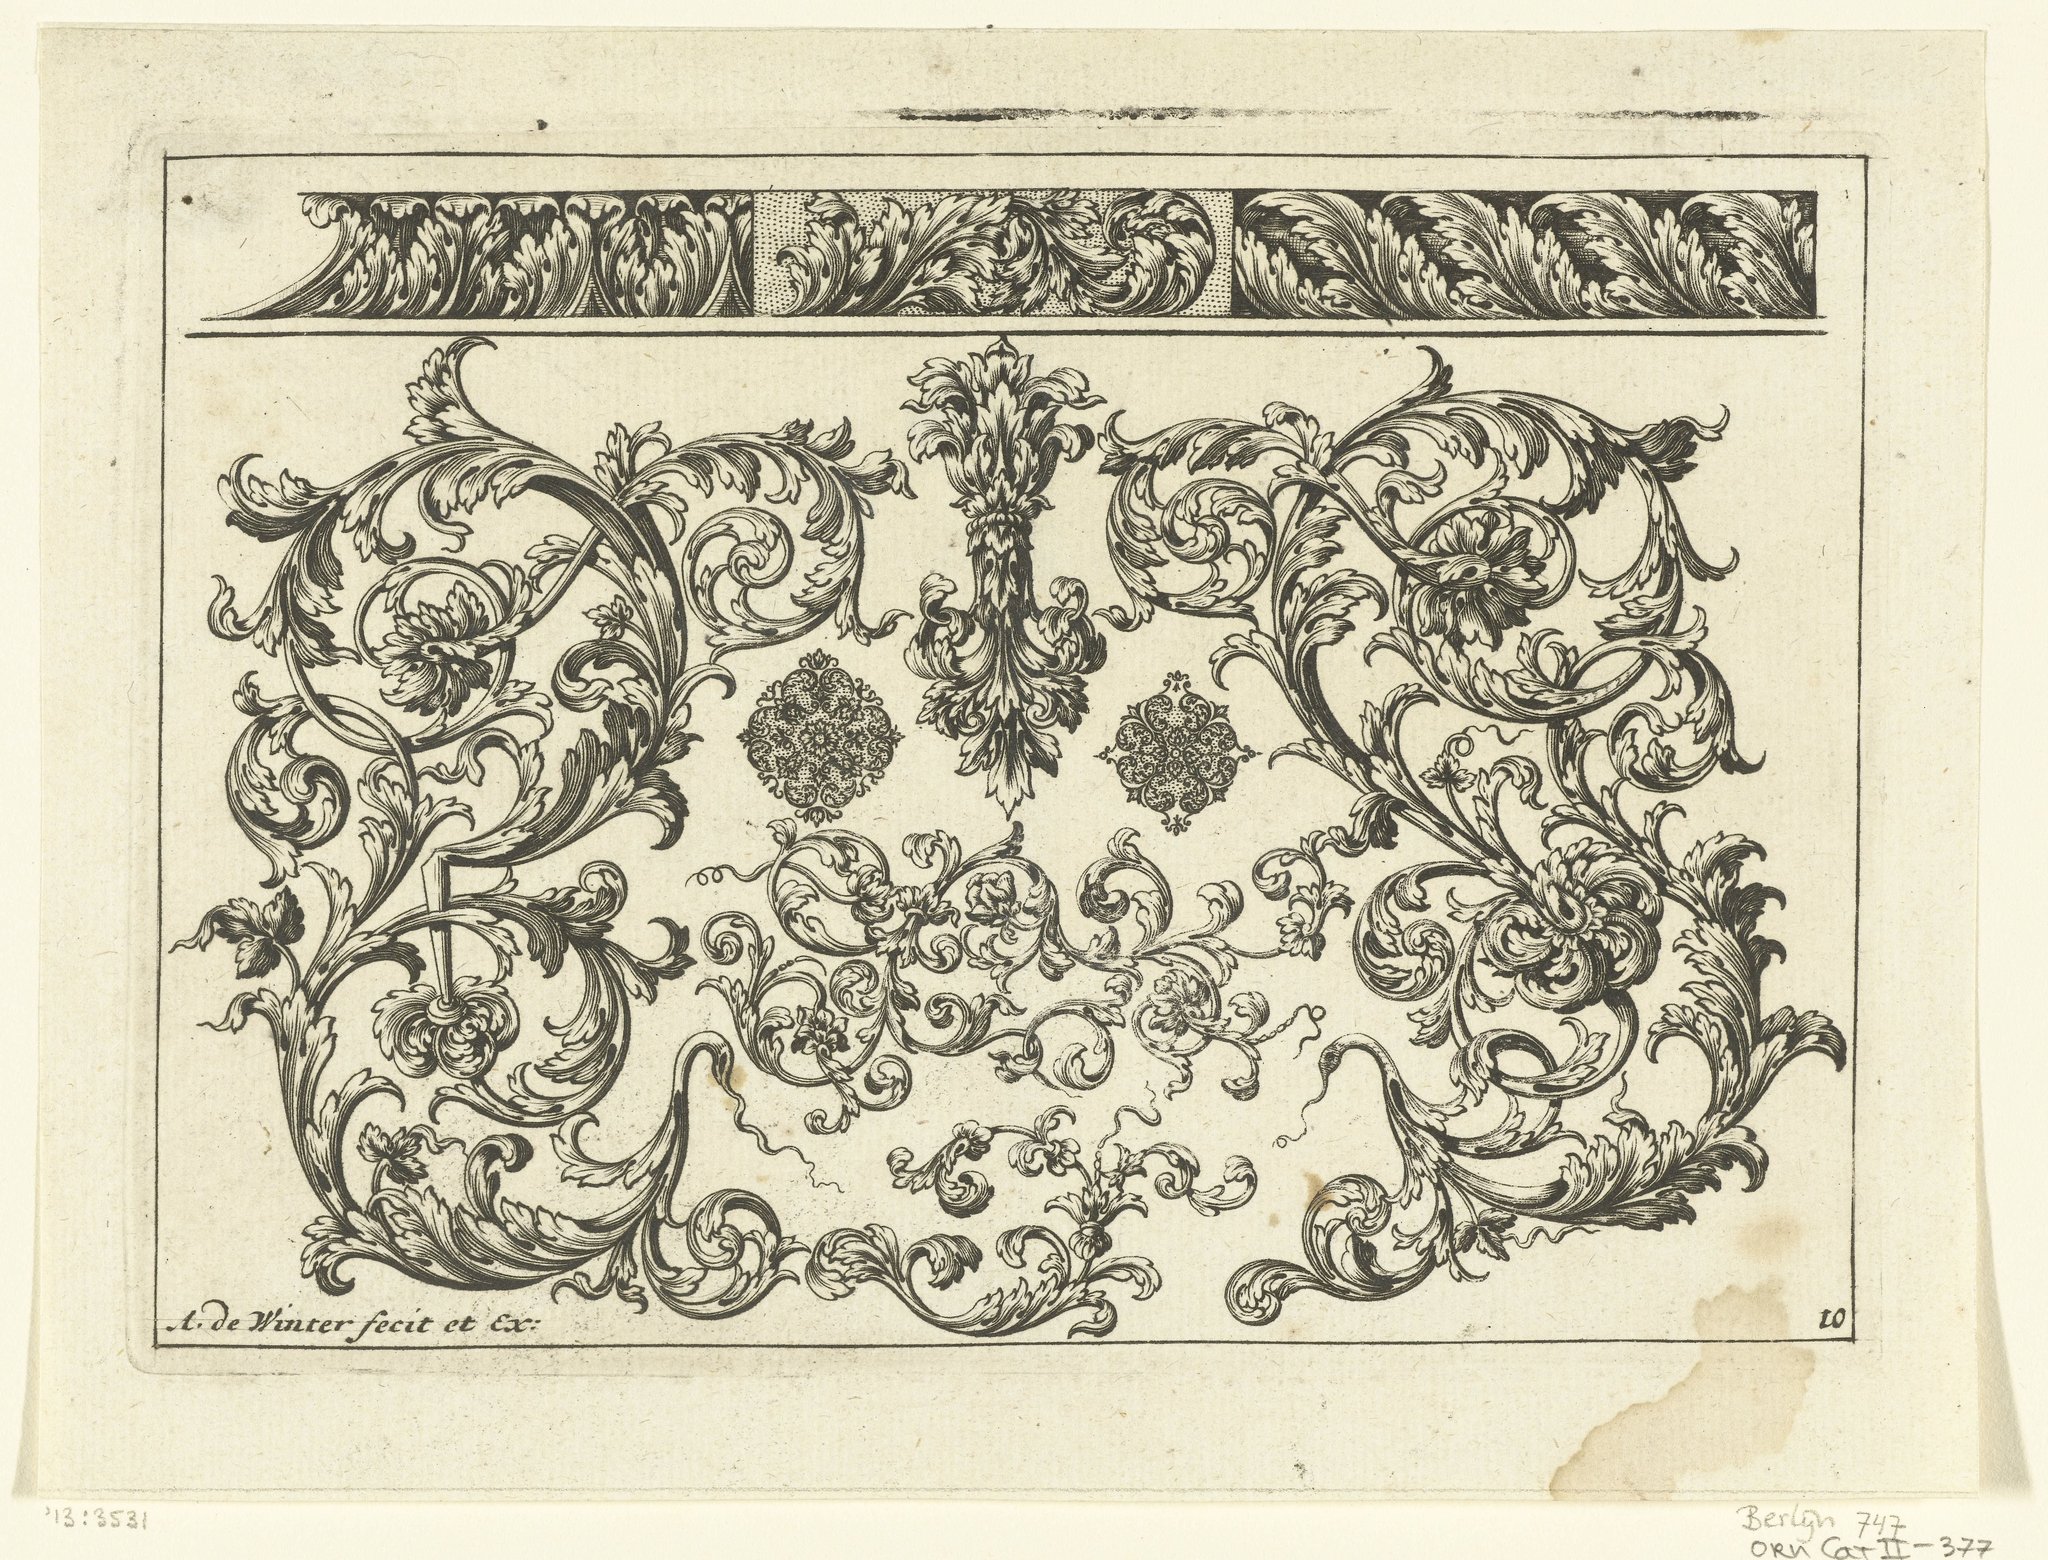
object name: print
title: Acht motieven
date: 1690-1700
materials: paper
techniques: engraving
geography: amsterdam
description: Bovenaan een strook met drie variaties voor een ornamentele rand. Verder zijn bladranken, bladmotieven en twee rozetten te zien. Blad uit serie met kopieën naar Stefano della Bella, Gilles Légaré, Thomas Lejuge en anderen.